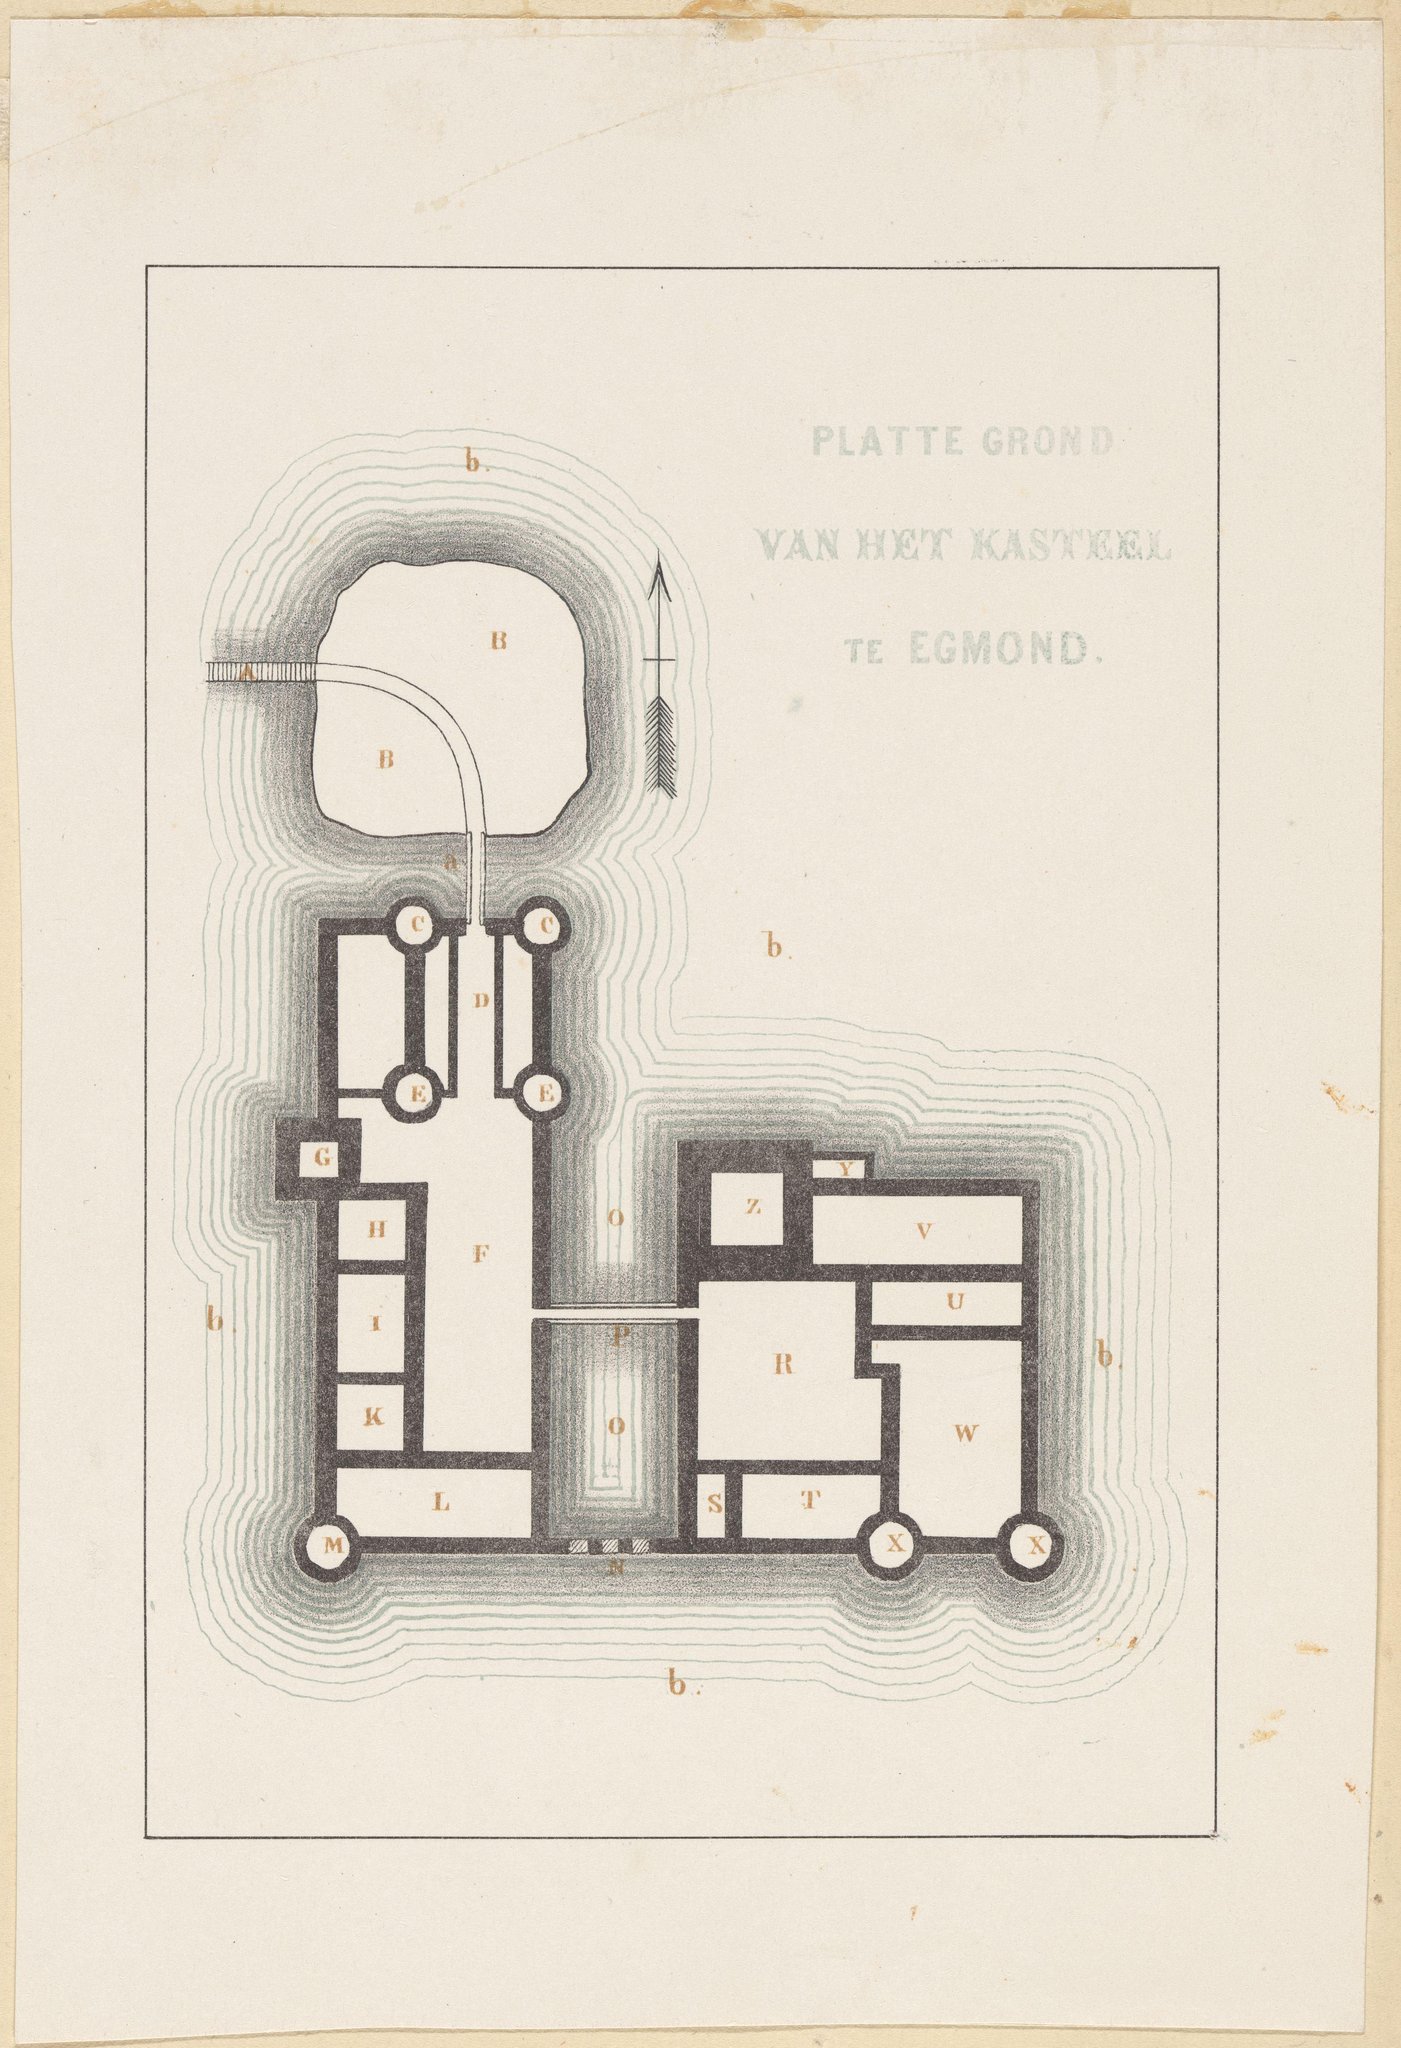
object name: print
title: Plattegrond van het kasteel te Egmond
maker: Anonymous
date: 1854-1861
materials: paper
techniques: tone lithography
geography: the hague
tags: castle, plan ~ architecture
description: Deze prent is samen met RP-P-1914-4444 opgezet. Uitgegeven in: Lennep, J. van, Merkwaardige Kasteelen in Nederland. Amsterdam, G. W. Tielkemeijer: 1854-1861.